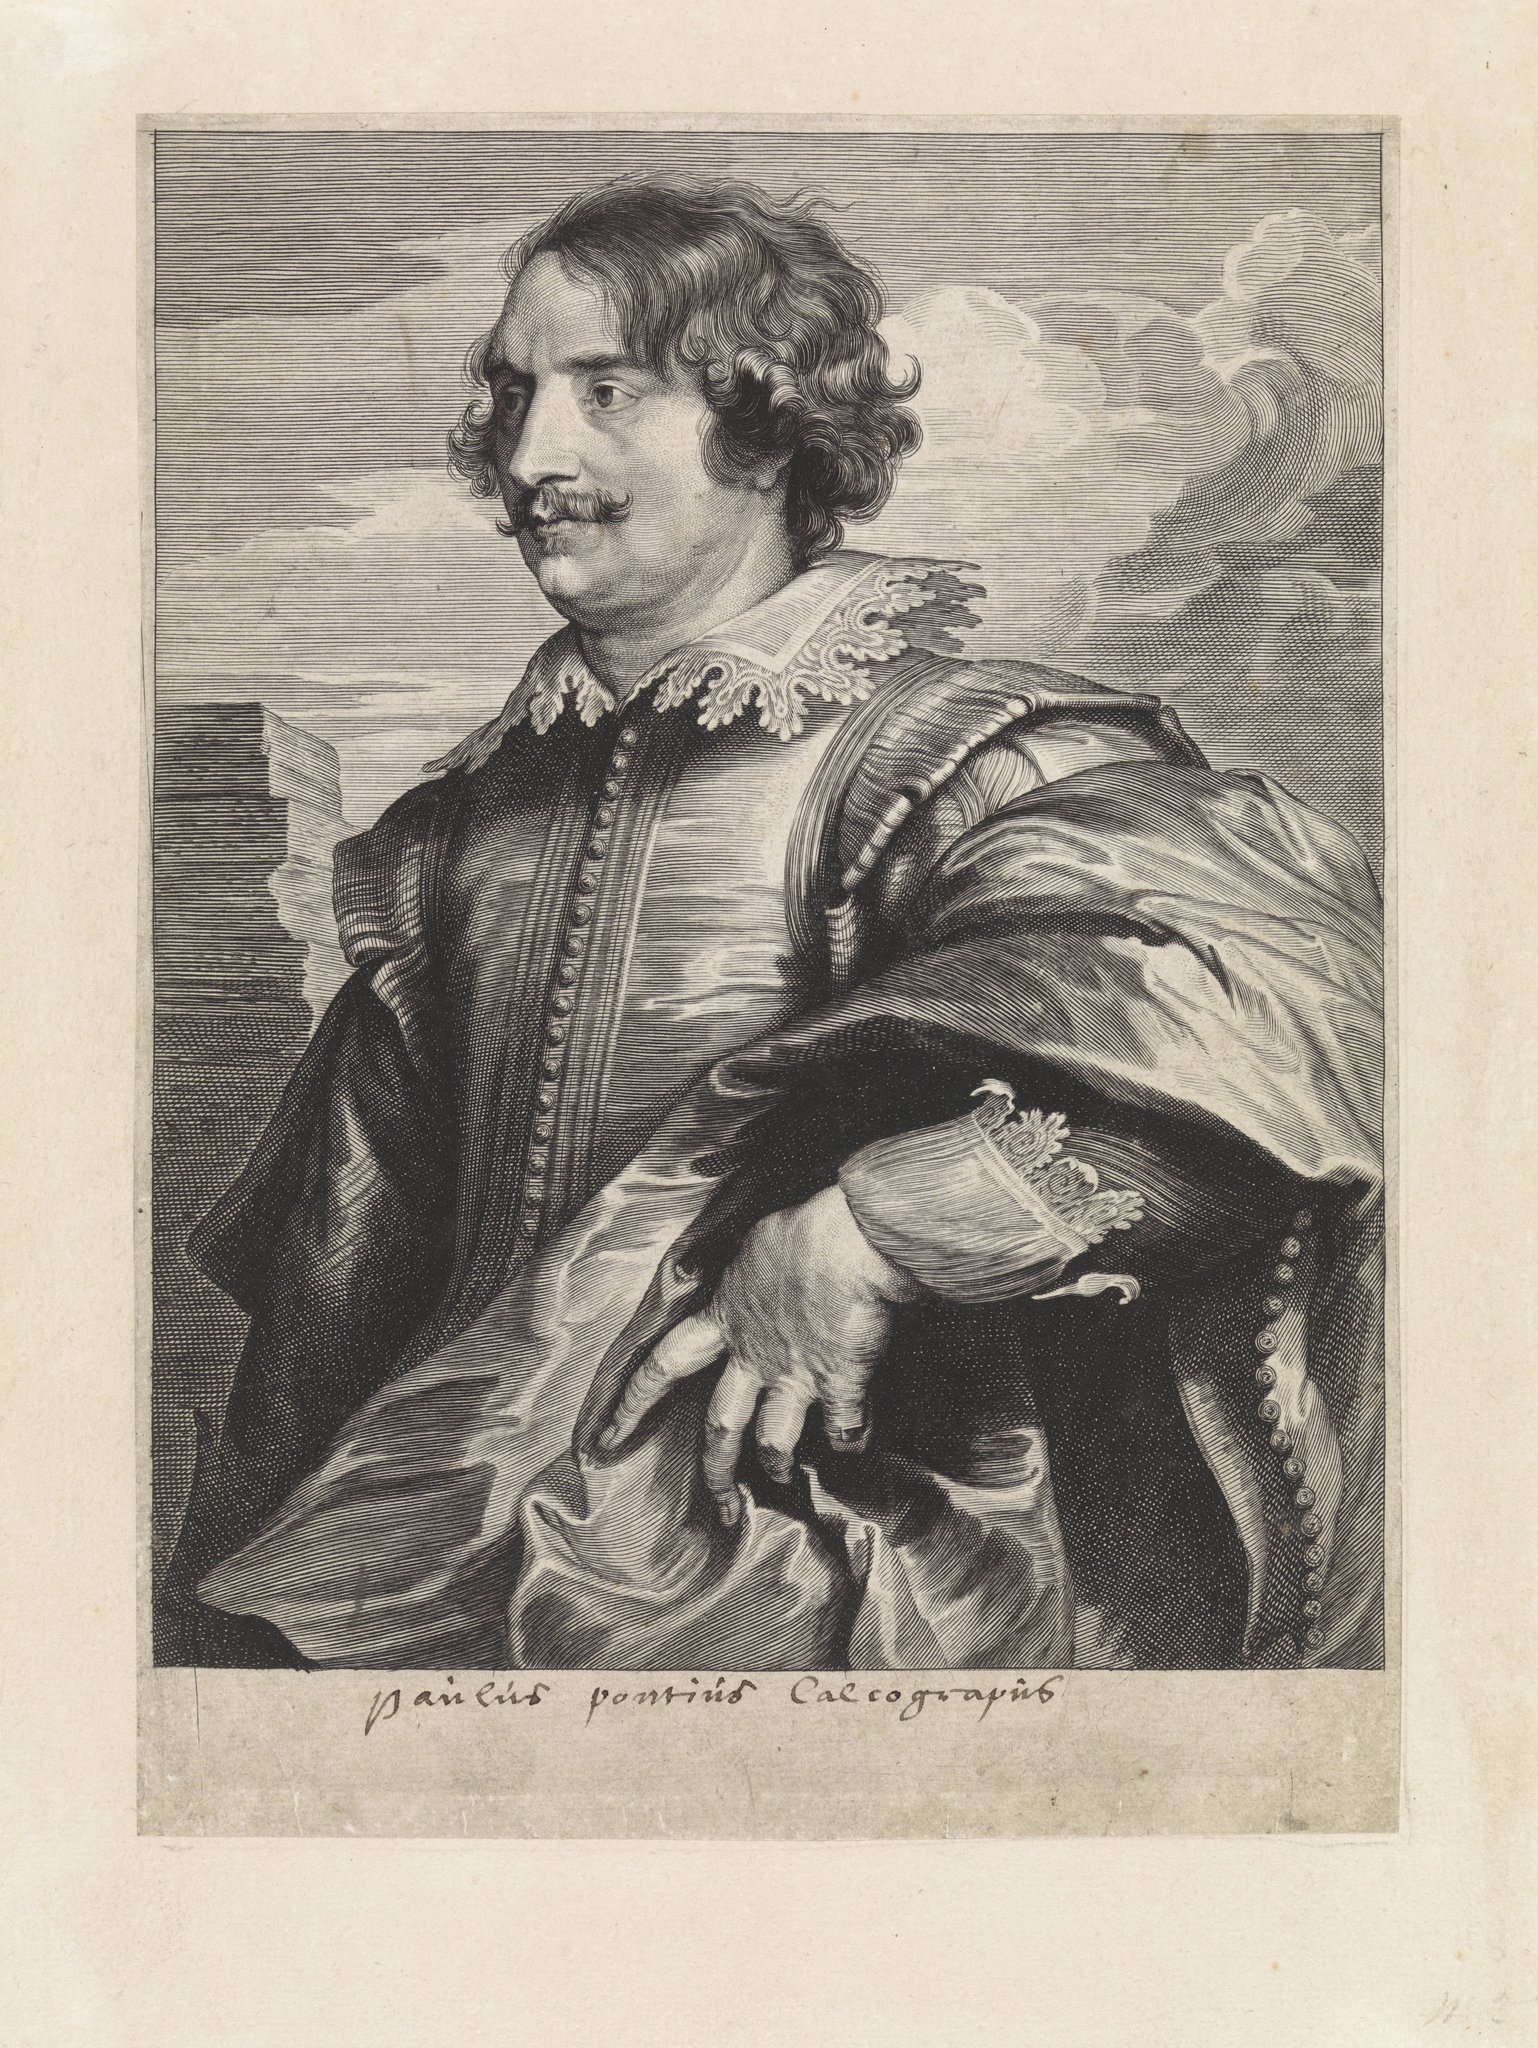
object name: print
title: Portret van de graveur Paulus Pontius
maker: paulus pontius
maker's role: draughtsman, print maker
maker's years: 1603-1658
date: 1616-1657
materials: paper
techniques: engraving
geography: antwerp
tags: paulus pontius, portrait, self-portrait of graphic artist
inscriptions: collector's mark: Lugt 240, inscription: ‘Paulus Pontius Calcographus’